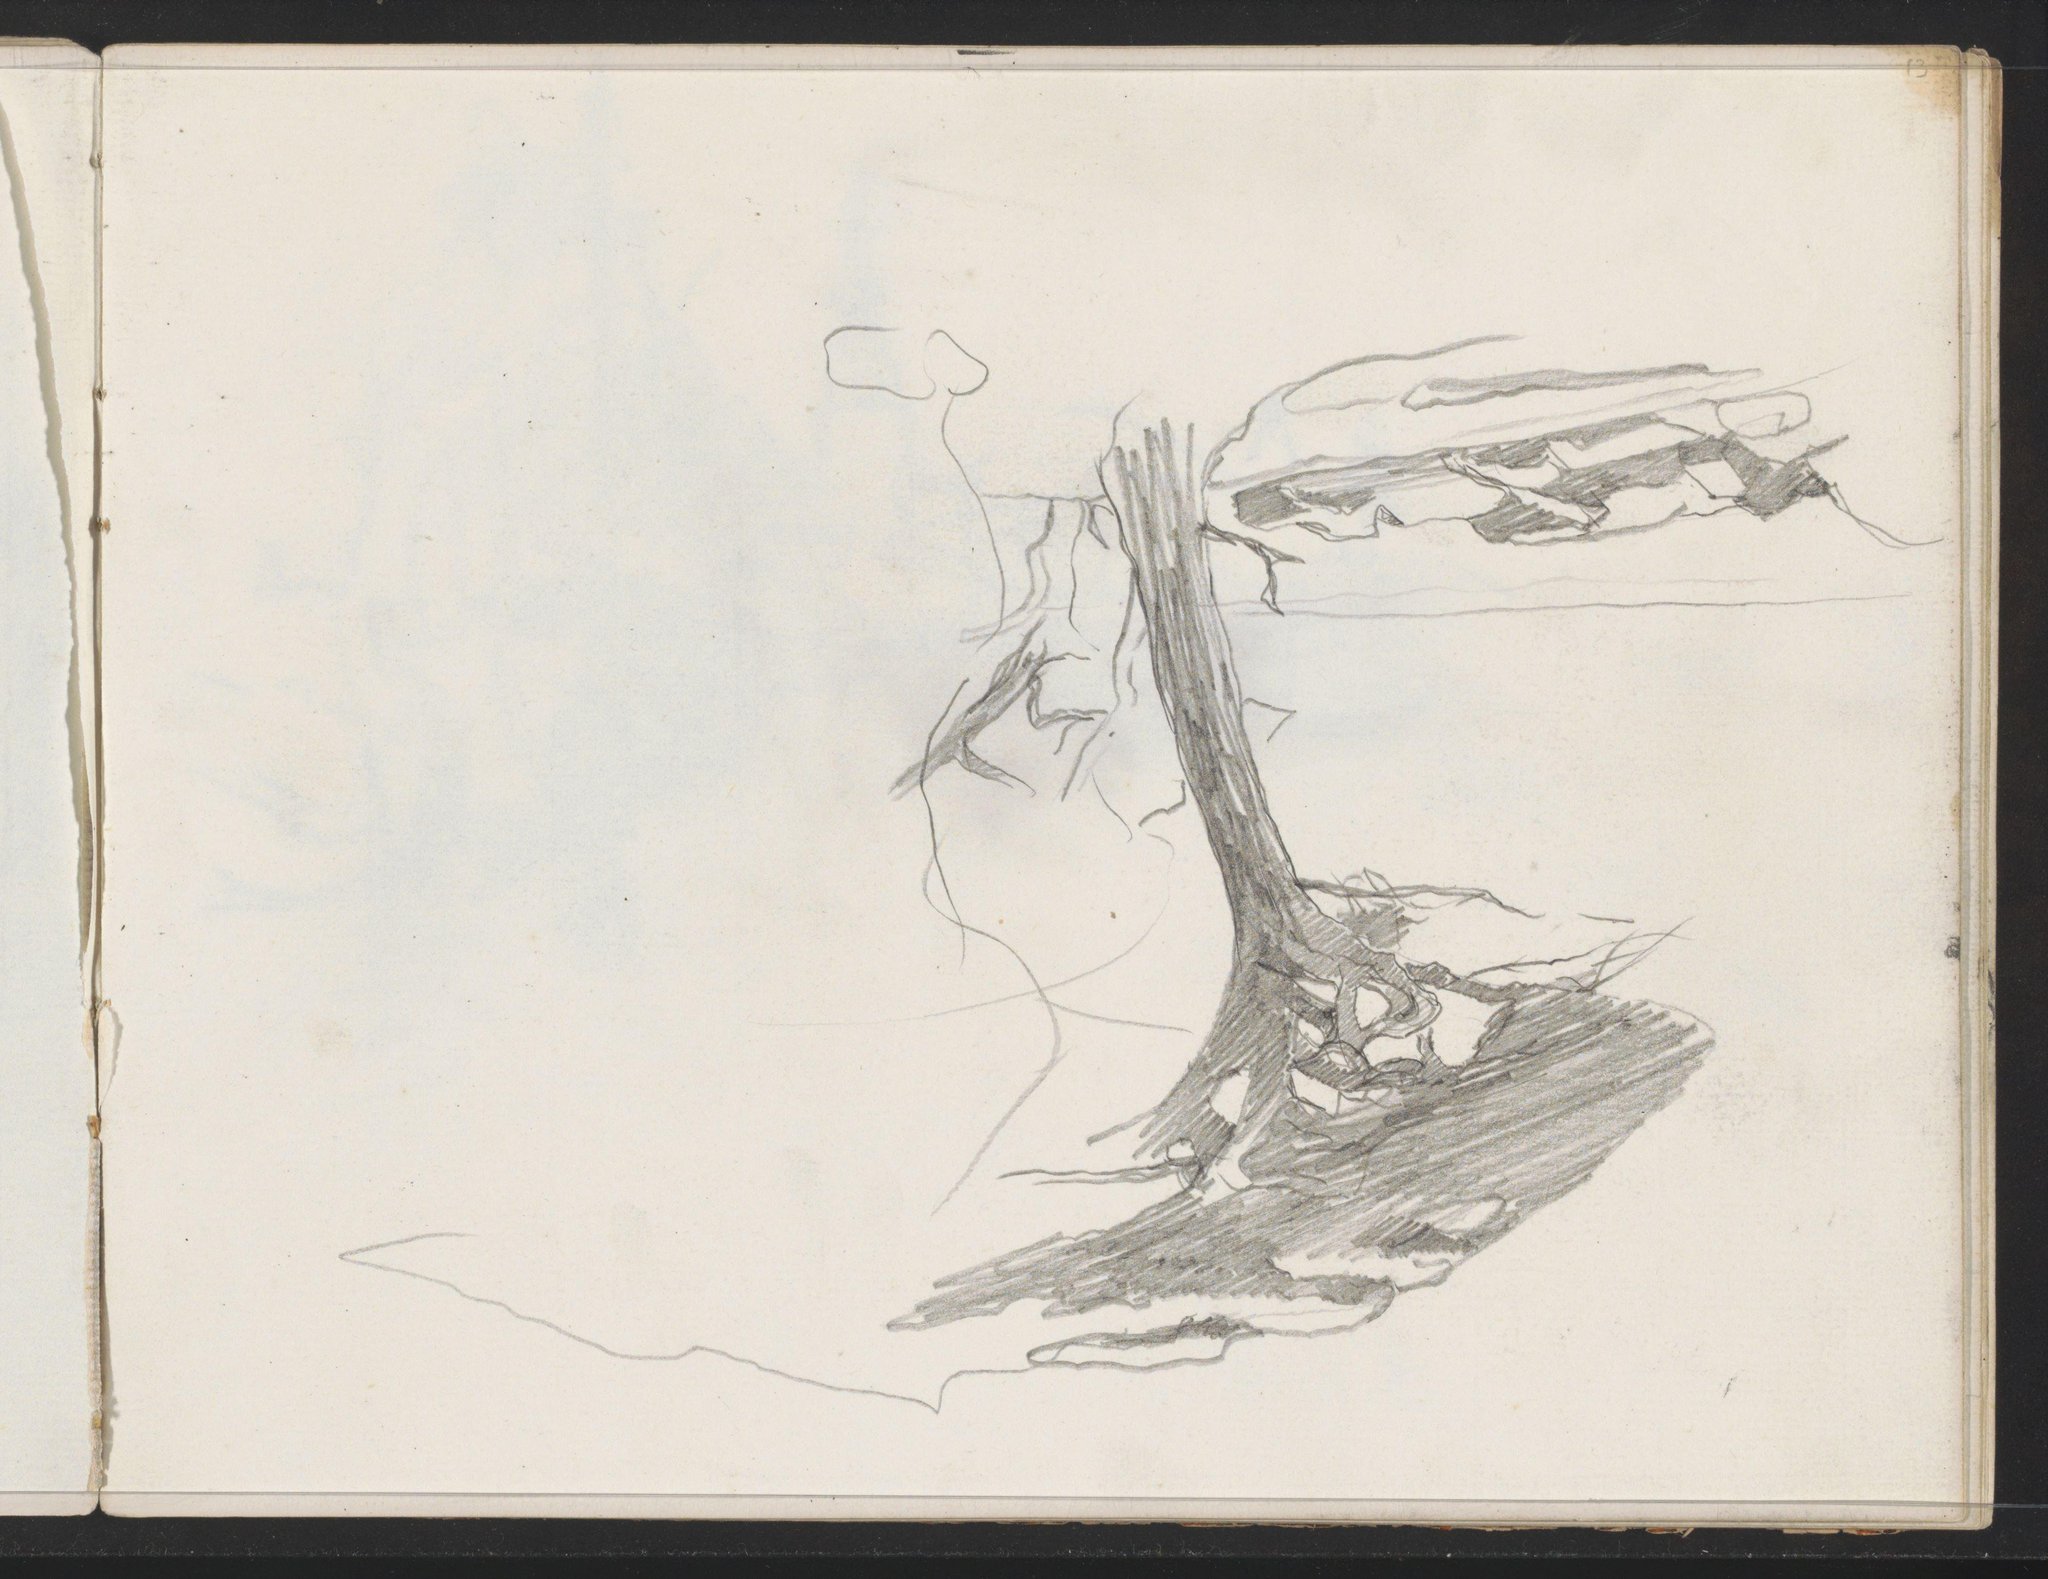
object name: sketchbook leaf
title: Boom aan de kust bij St. Andrews te Canada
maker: willem witsen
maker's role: draughtsman, painter, print maker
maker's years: 1860-1923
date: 1915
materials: paper, pencil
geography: st. andrews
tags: trees, rocky coast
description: Voorstudie voor de ets 'Rotsige kust bij St. Andrews, Canada', ca. 1915-1919.